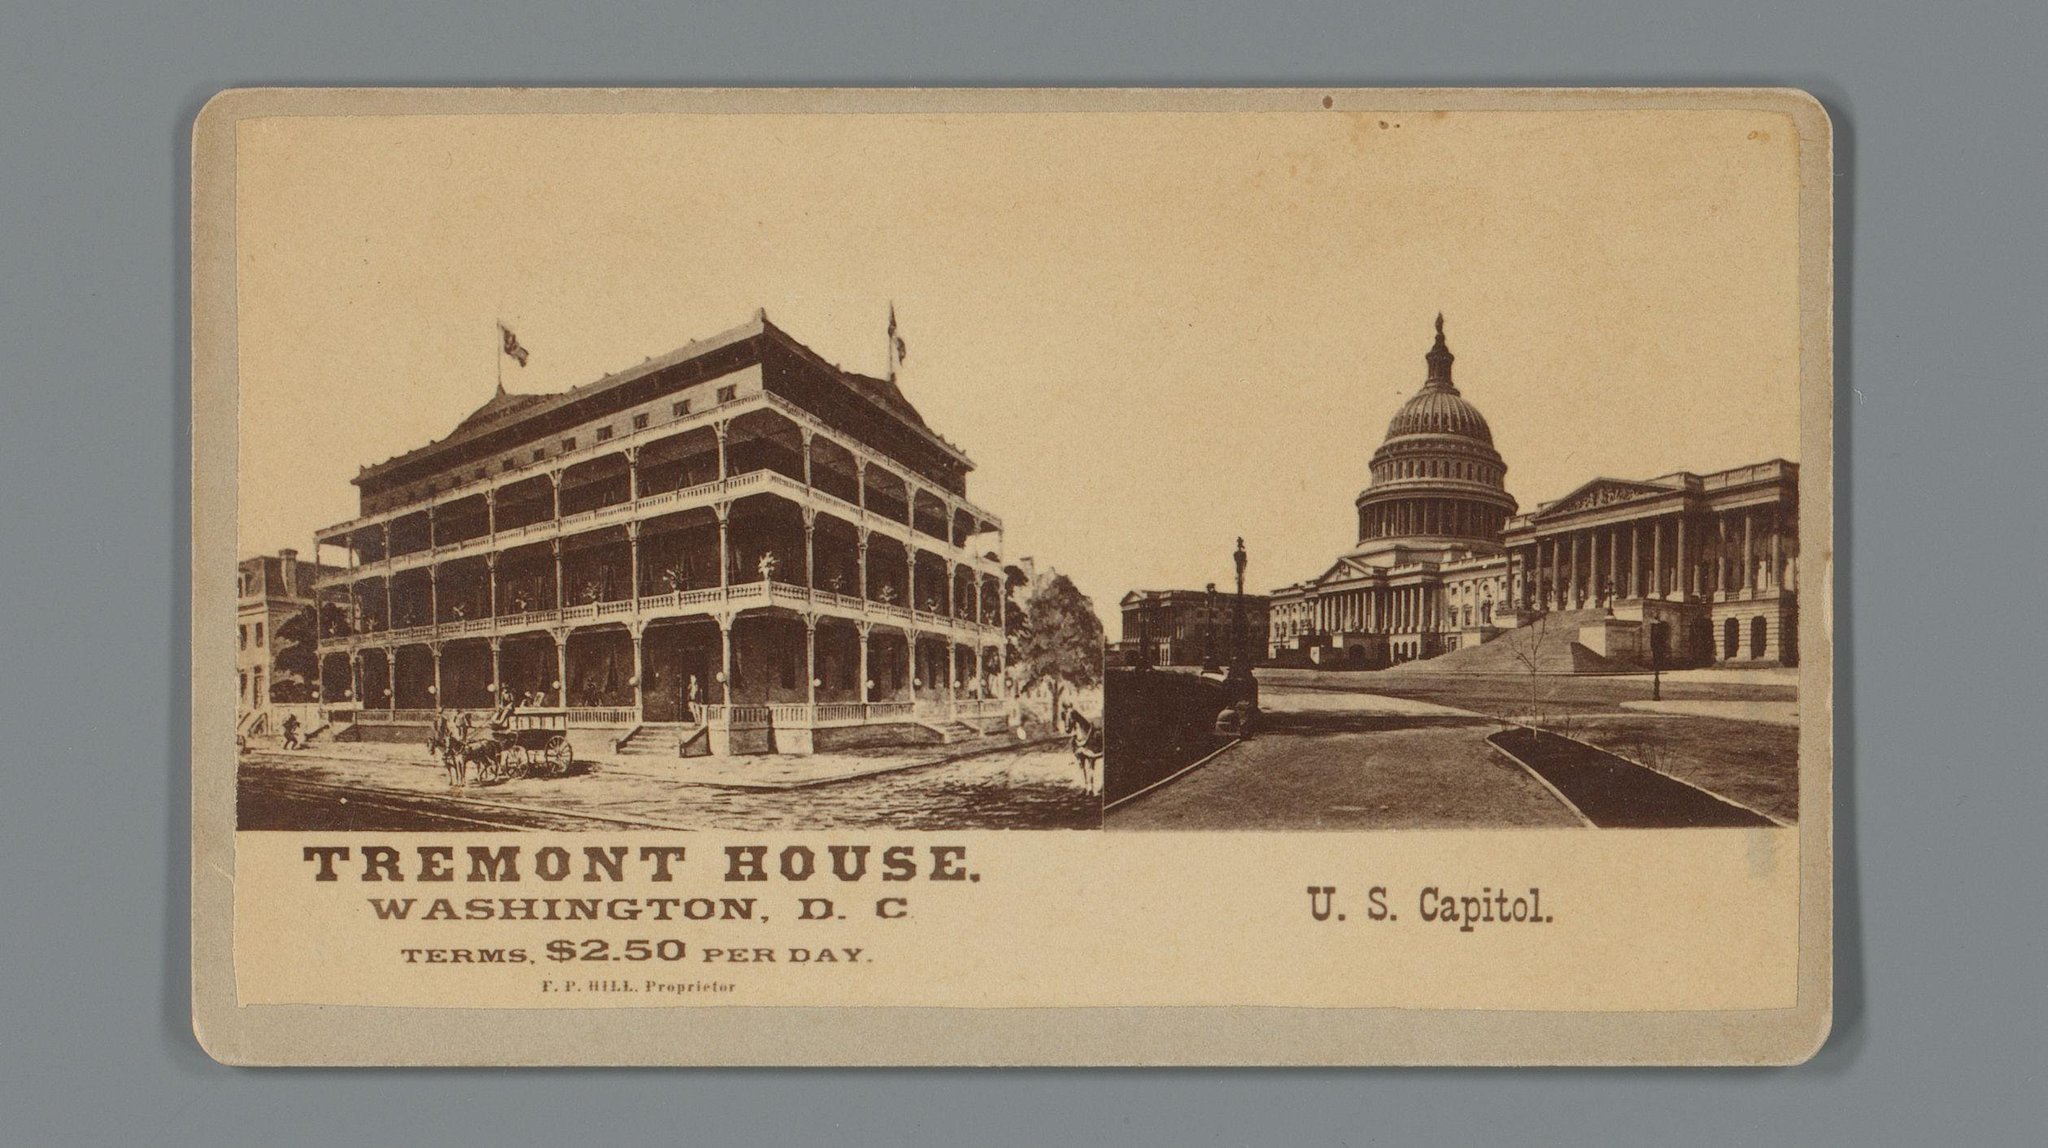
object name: photograph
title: Gezicht op voormalig hotel Tremont House en het Capitool in Washington D.C., Verenigde Staten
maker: Anonymous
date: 1850-1915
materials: cardboard, photographic support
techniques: albumen print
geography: washington d.c.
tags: court building, advertising, hotel, hostelry, inn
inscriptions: inscription: ‘TREMONT HOUSE/ WASHINGTON D.C./ TERMS $2.50 PER DAY./F.P. HILL Proprietor’